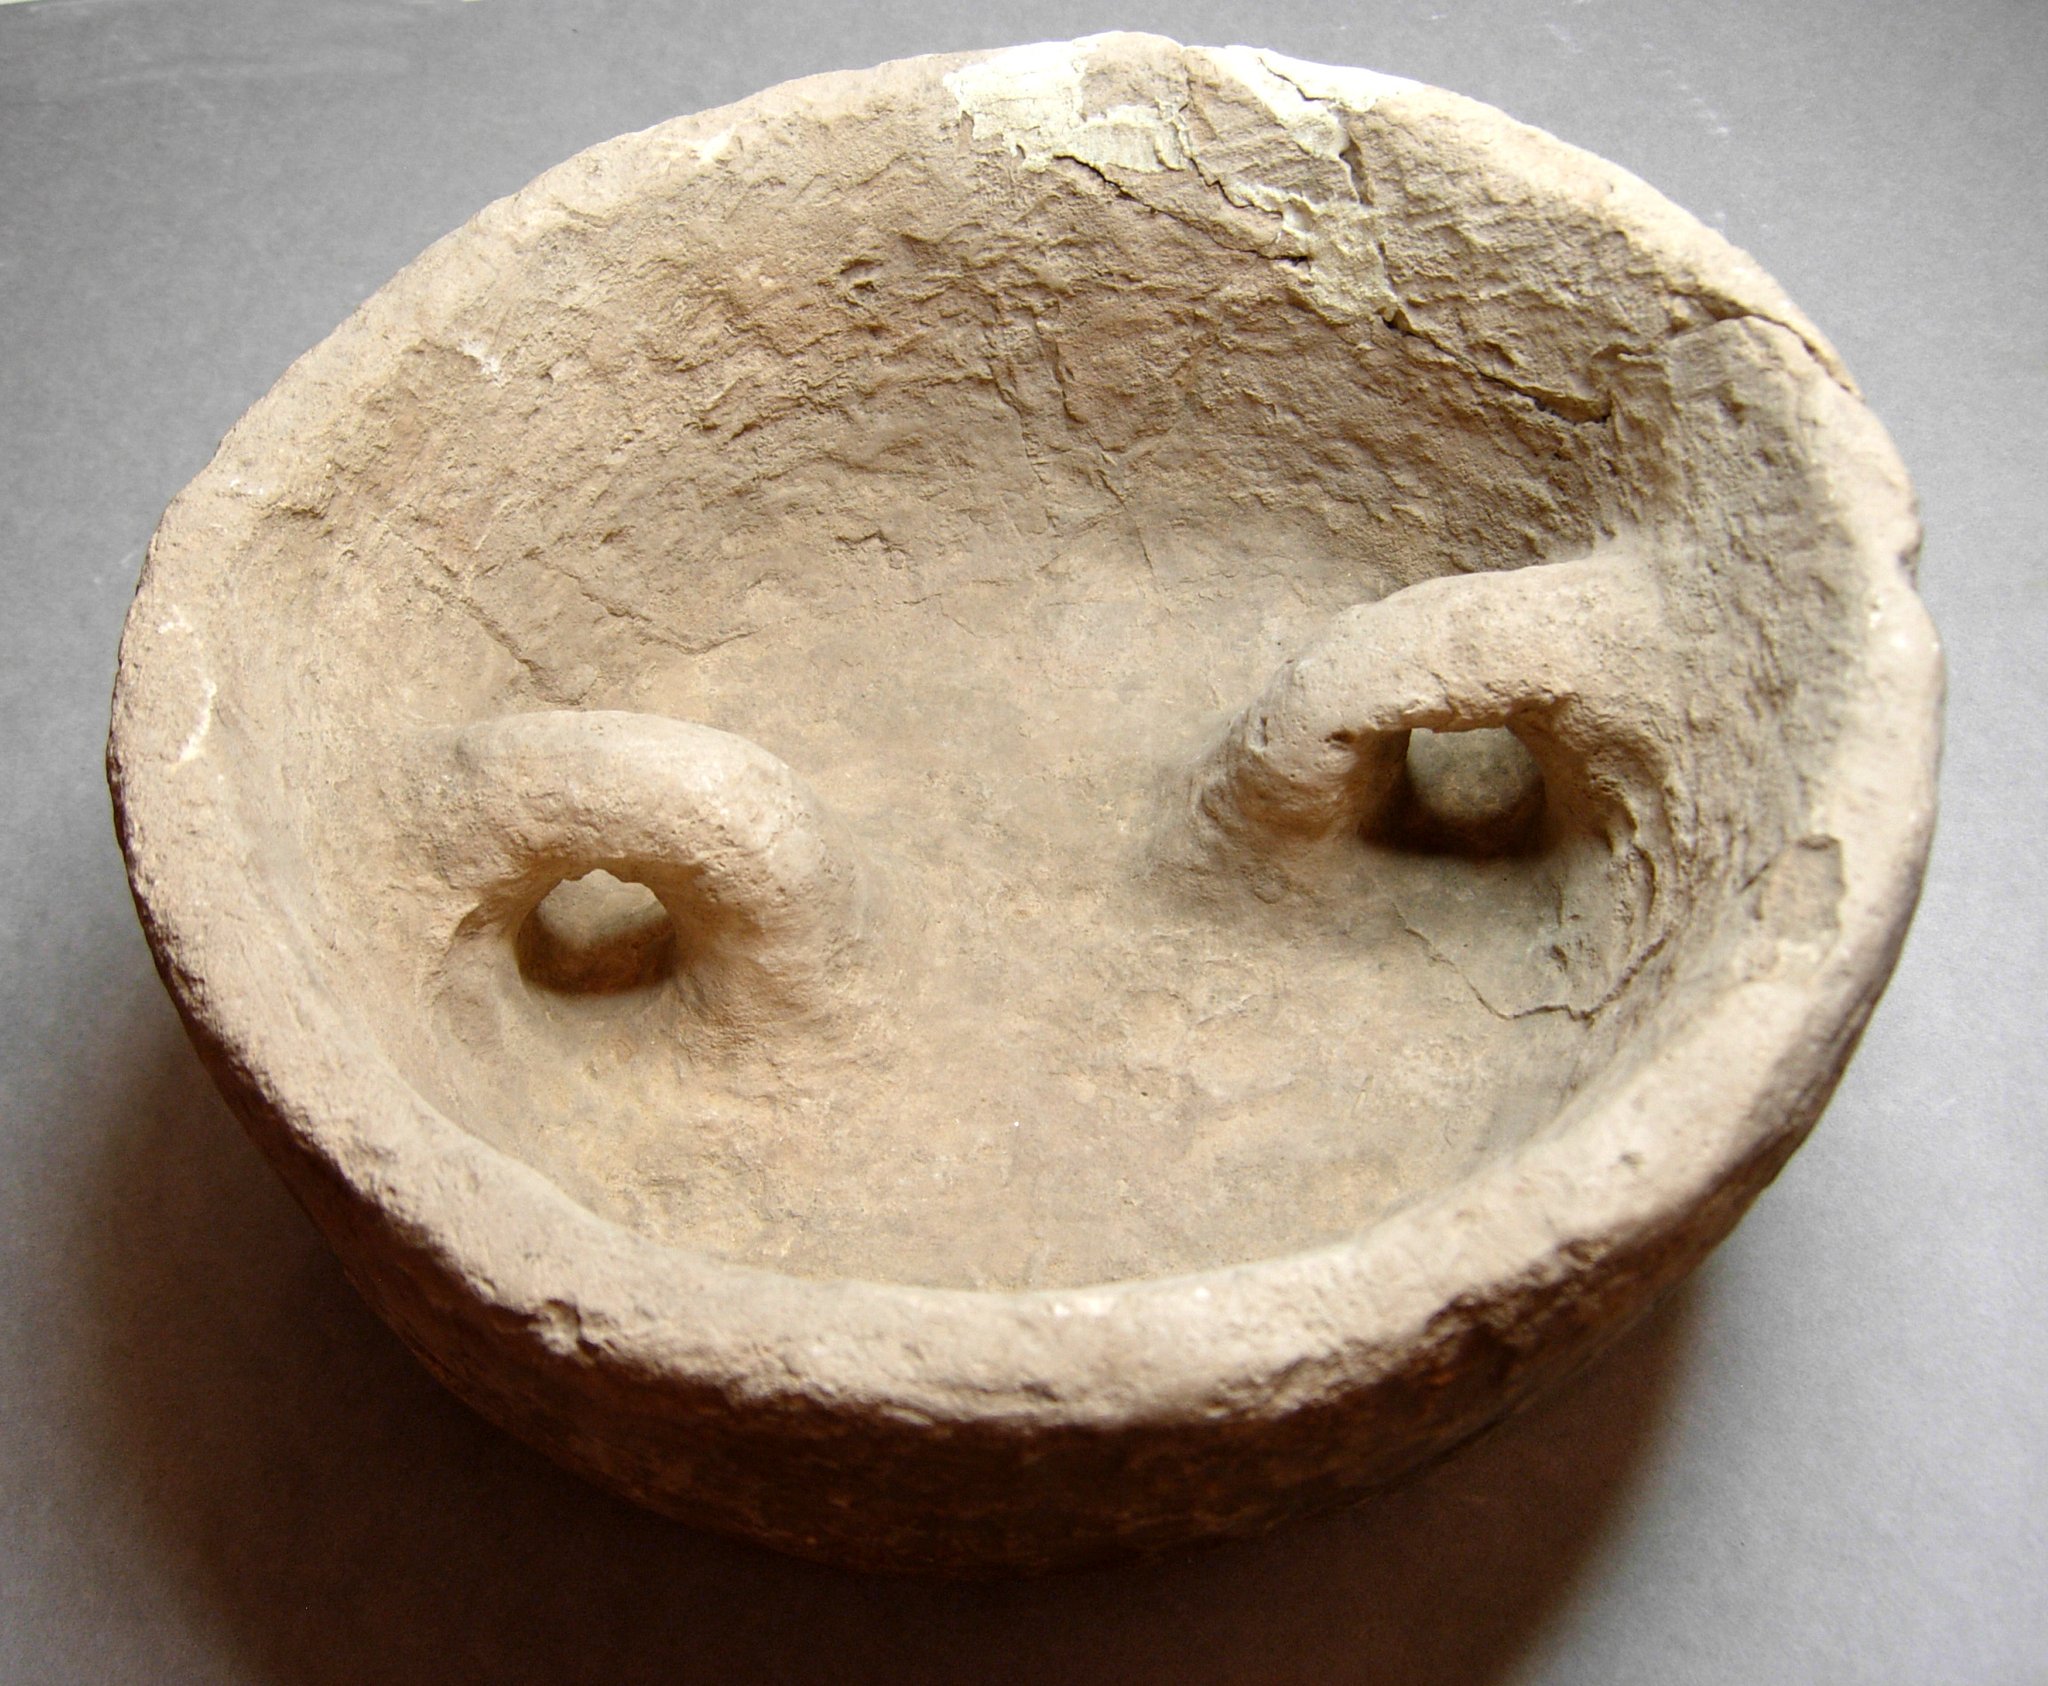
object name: spinning bowl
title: Dish for holding flax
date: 1295-1070 BCE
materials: limestone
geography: egypt